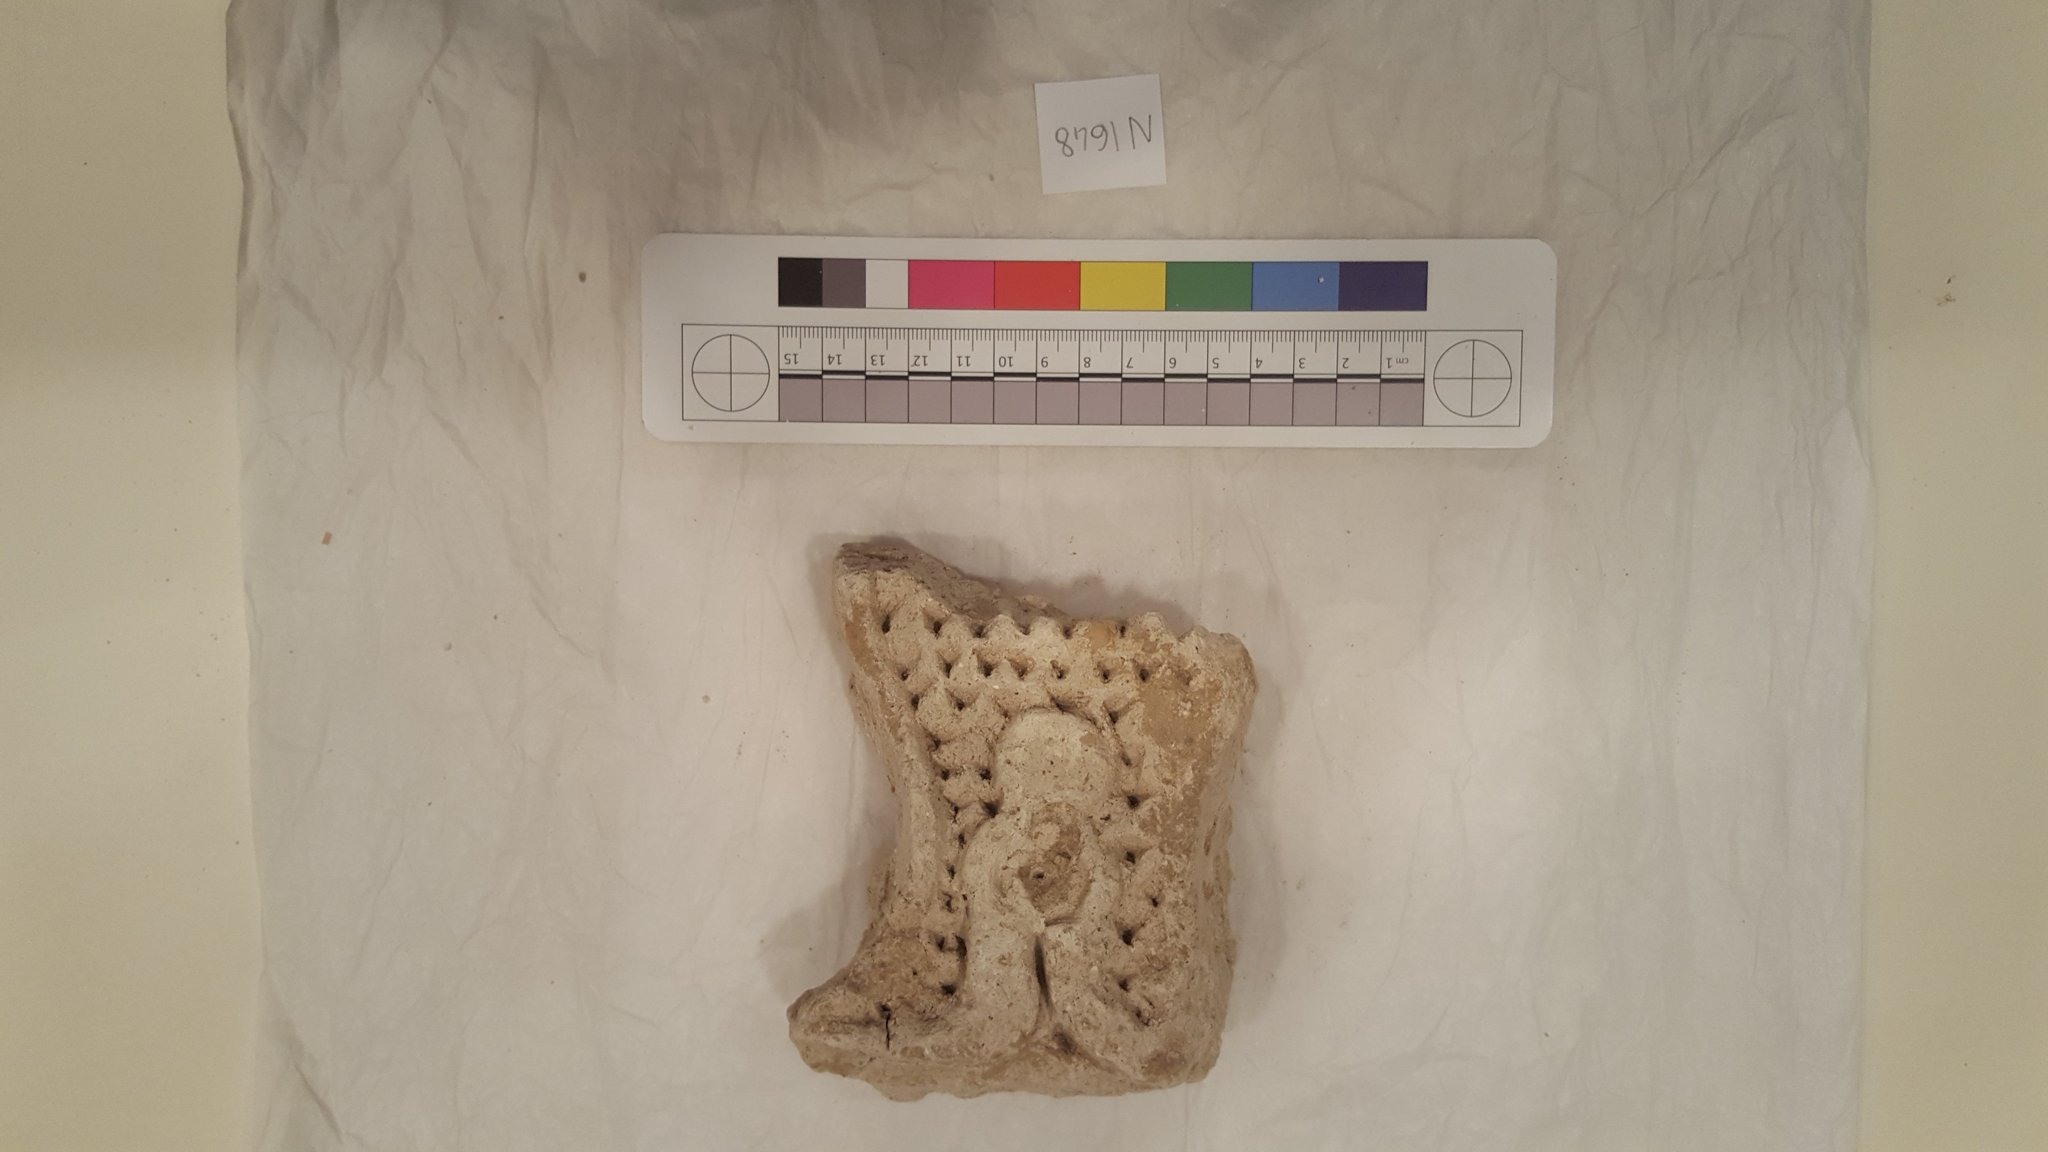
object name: fragment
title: Stucco Fragment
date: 701-1200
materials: plaster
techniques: carving, painting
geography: iran